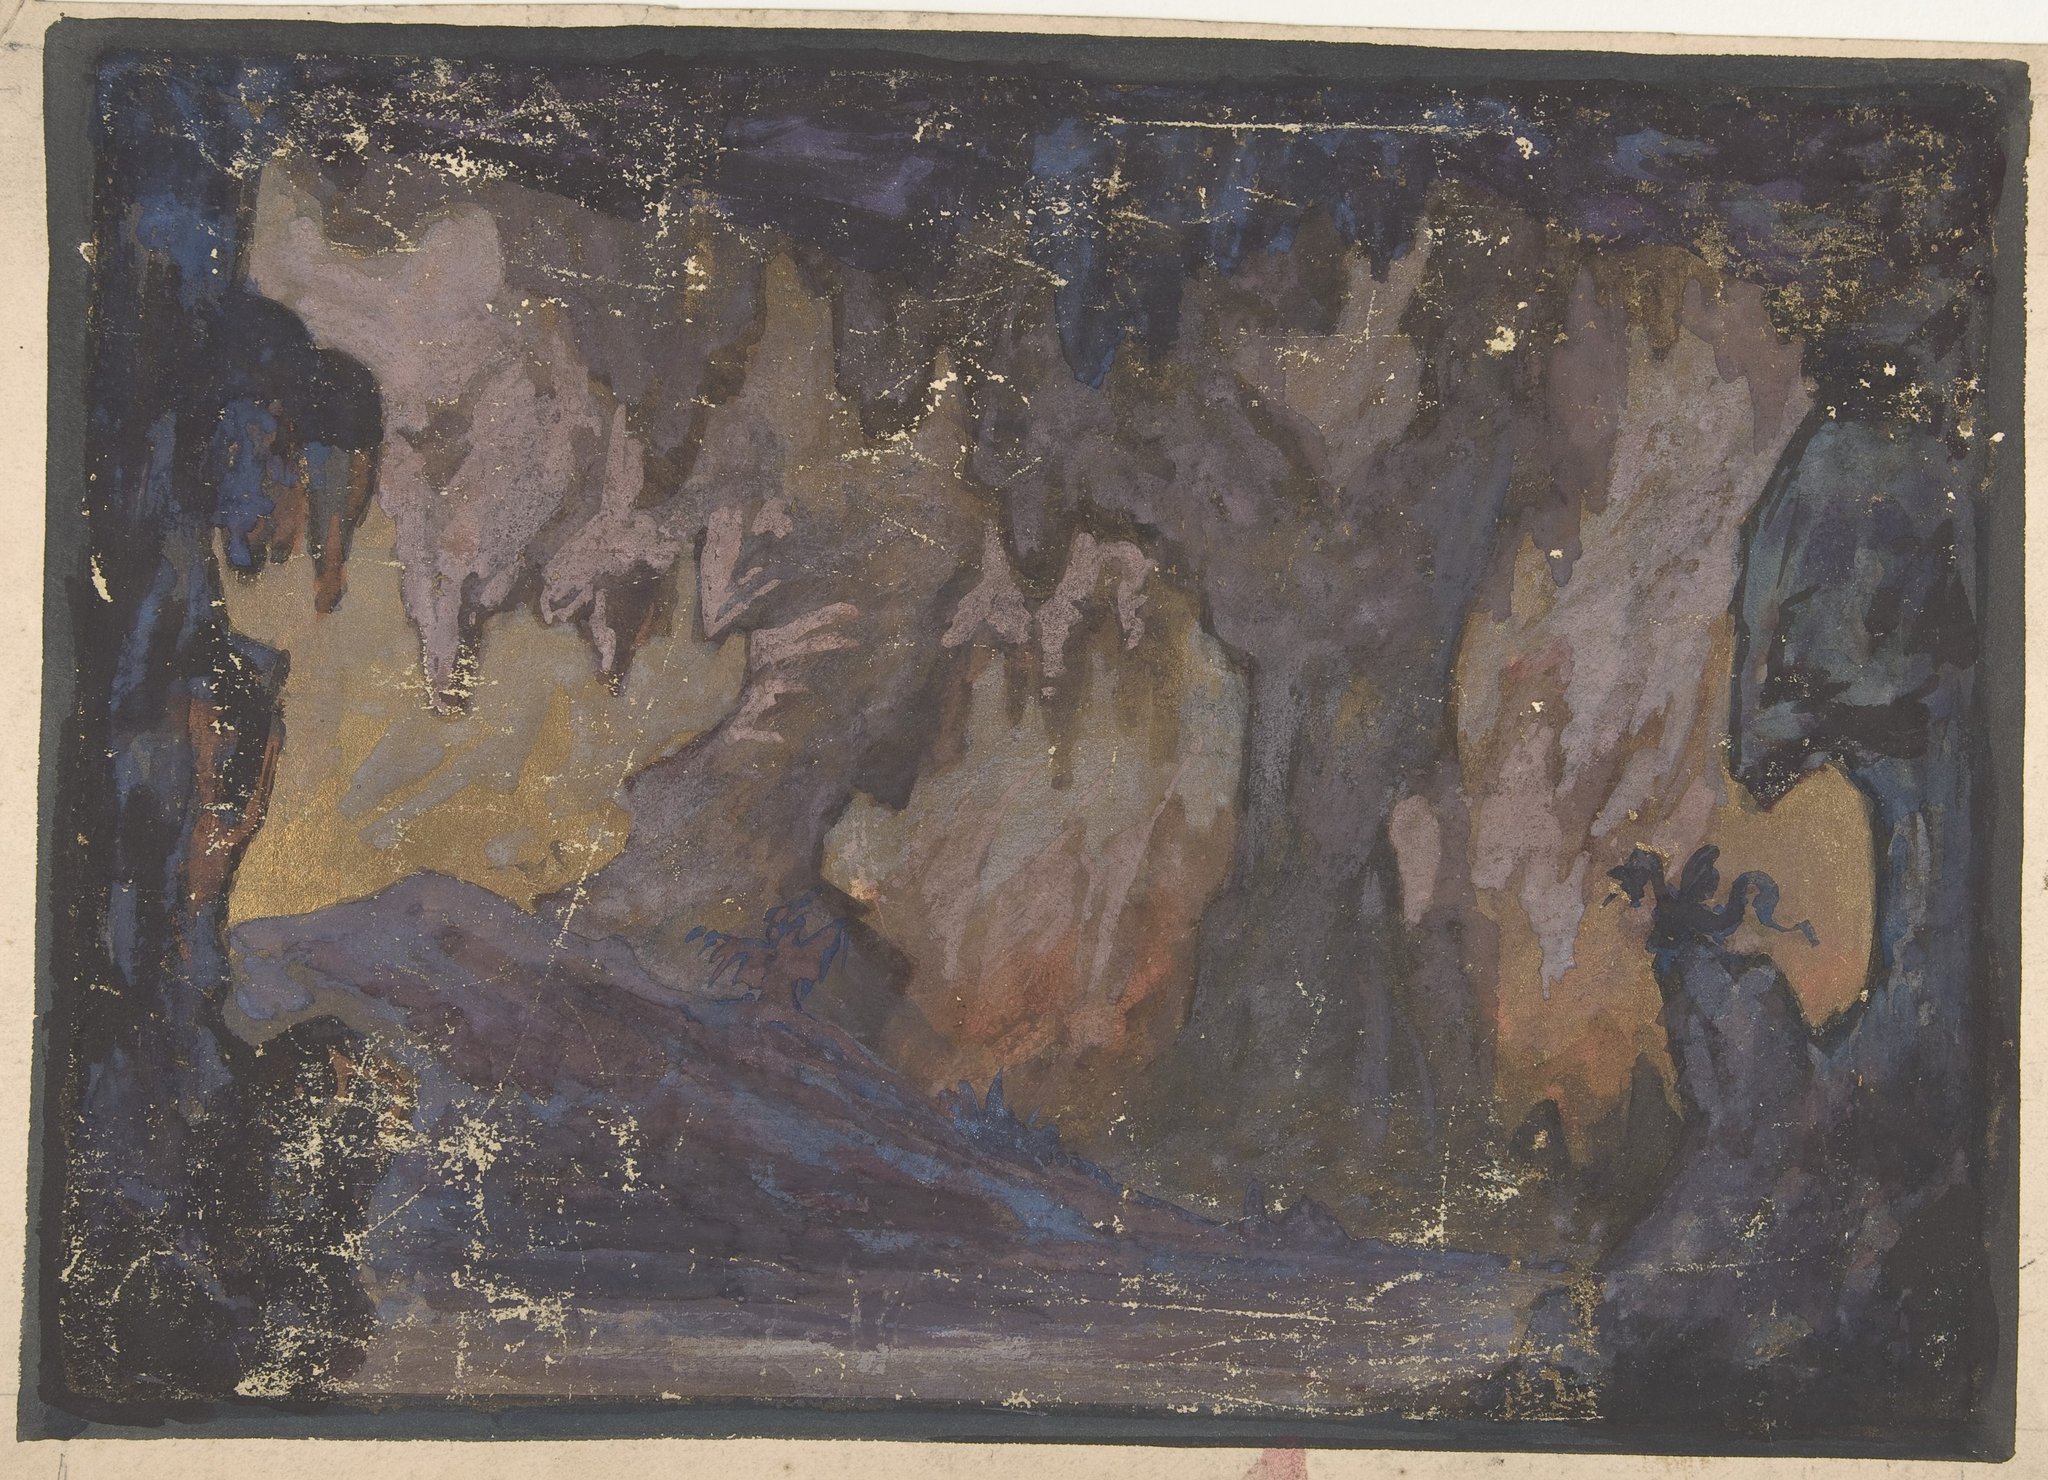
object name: drawing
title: Design for a Stage Set at the Opéra, Paris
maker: eugène cicéri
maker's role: artist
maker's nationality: french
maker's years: 1813-1890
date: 1830-1890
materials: gilt, gold, watercolor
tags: stage design